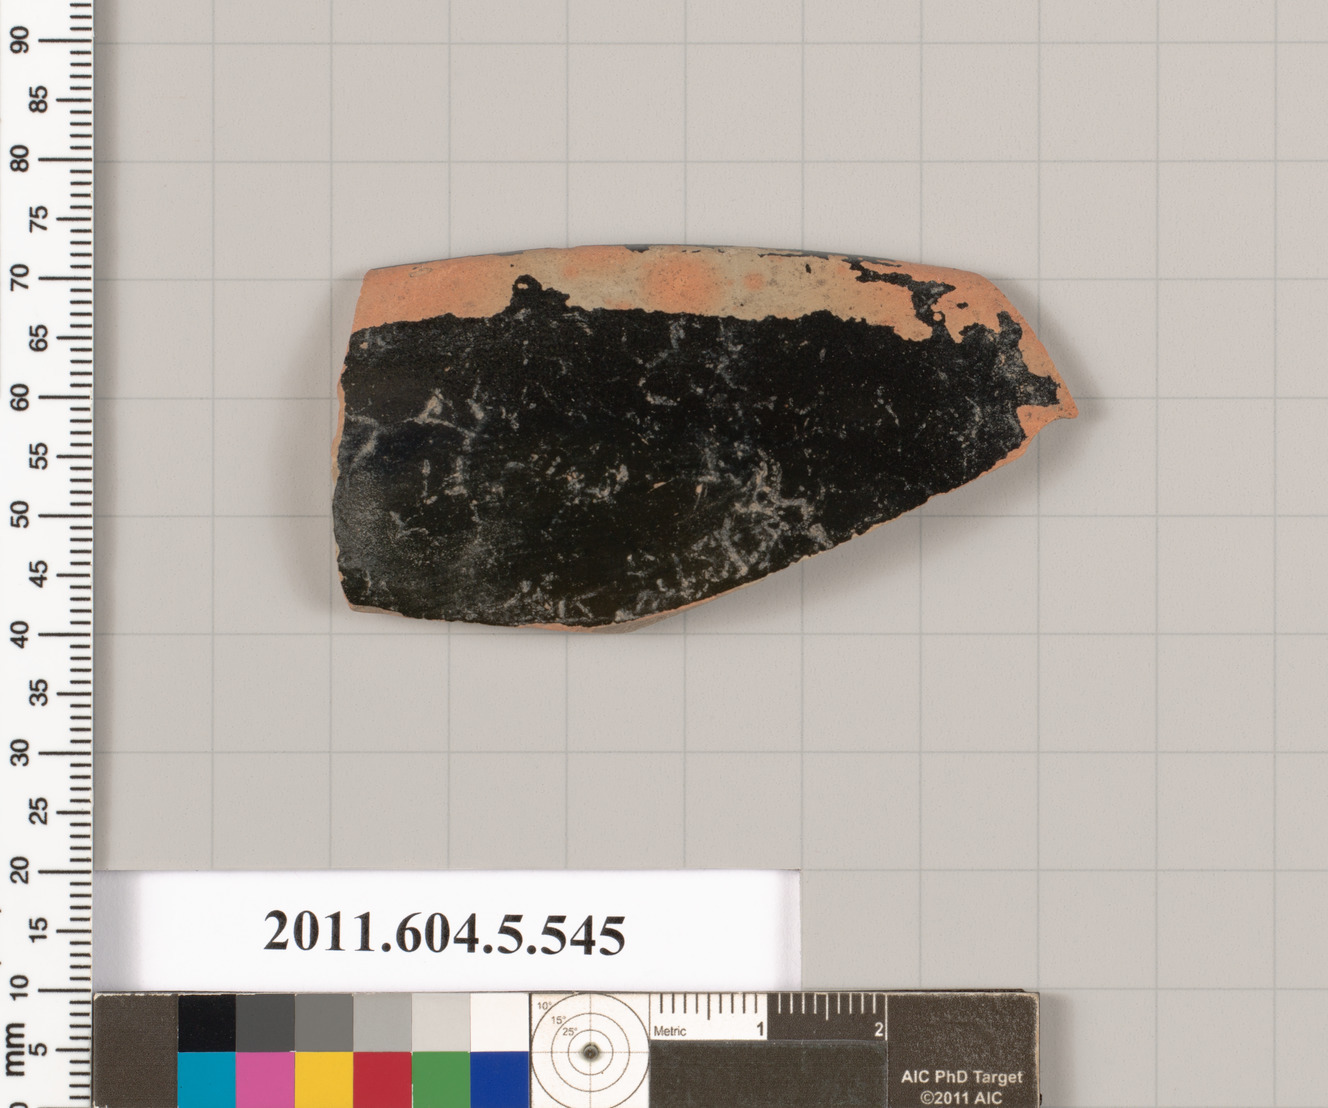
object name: kylix fragment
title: Terracotta rim fragment of a kylix (drinking cup)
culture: greek, attic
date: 600-401 BCE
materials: terracotta